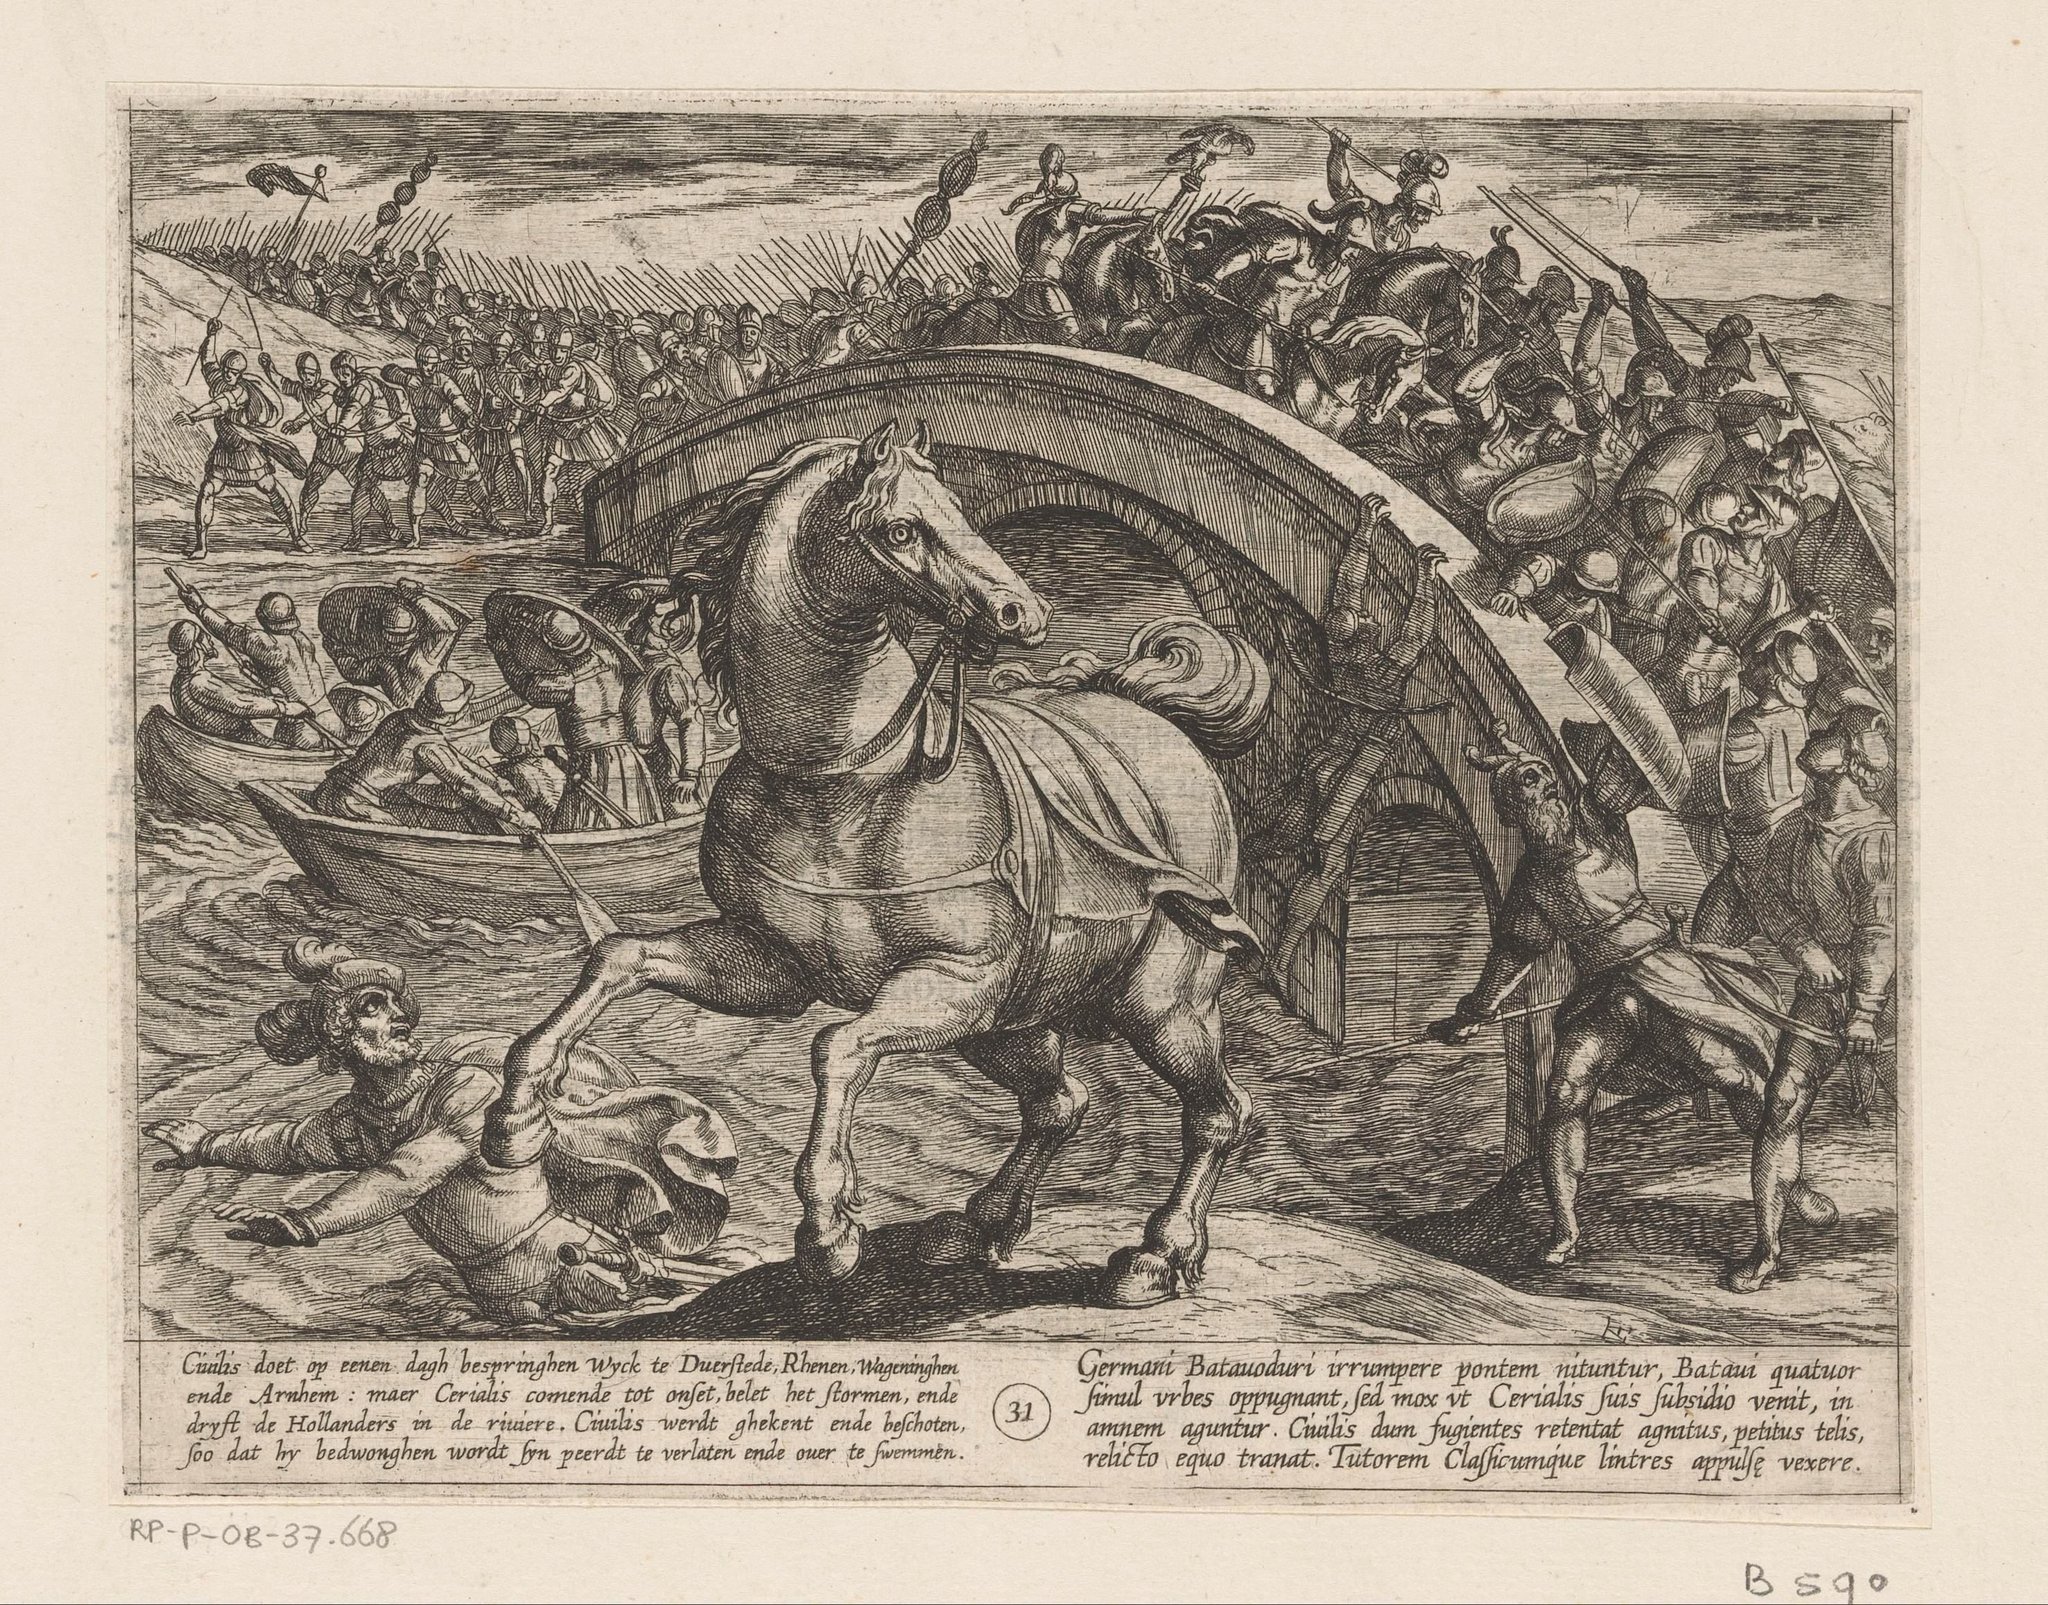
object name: print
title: De Bataafse oorlogen tegen de Romeinen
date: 1611-1612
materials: paper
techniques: etching, letterpress printing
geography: southern netherlands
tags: battle, the soldier; the soldier's life, retreat of the defeated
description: Julius Civilis wordt in de strijd tegen de Romeinen gedwongen af te stijgen van zijn paard en zwemmend de rivier over te steken. Het leger van Civilis moet ook terugtrekken. Onderschrift in het Nederlands en in het Latijn.